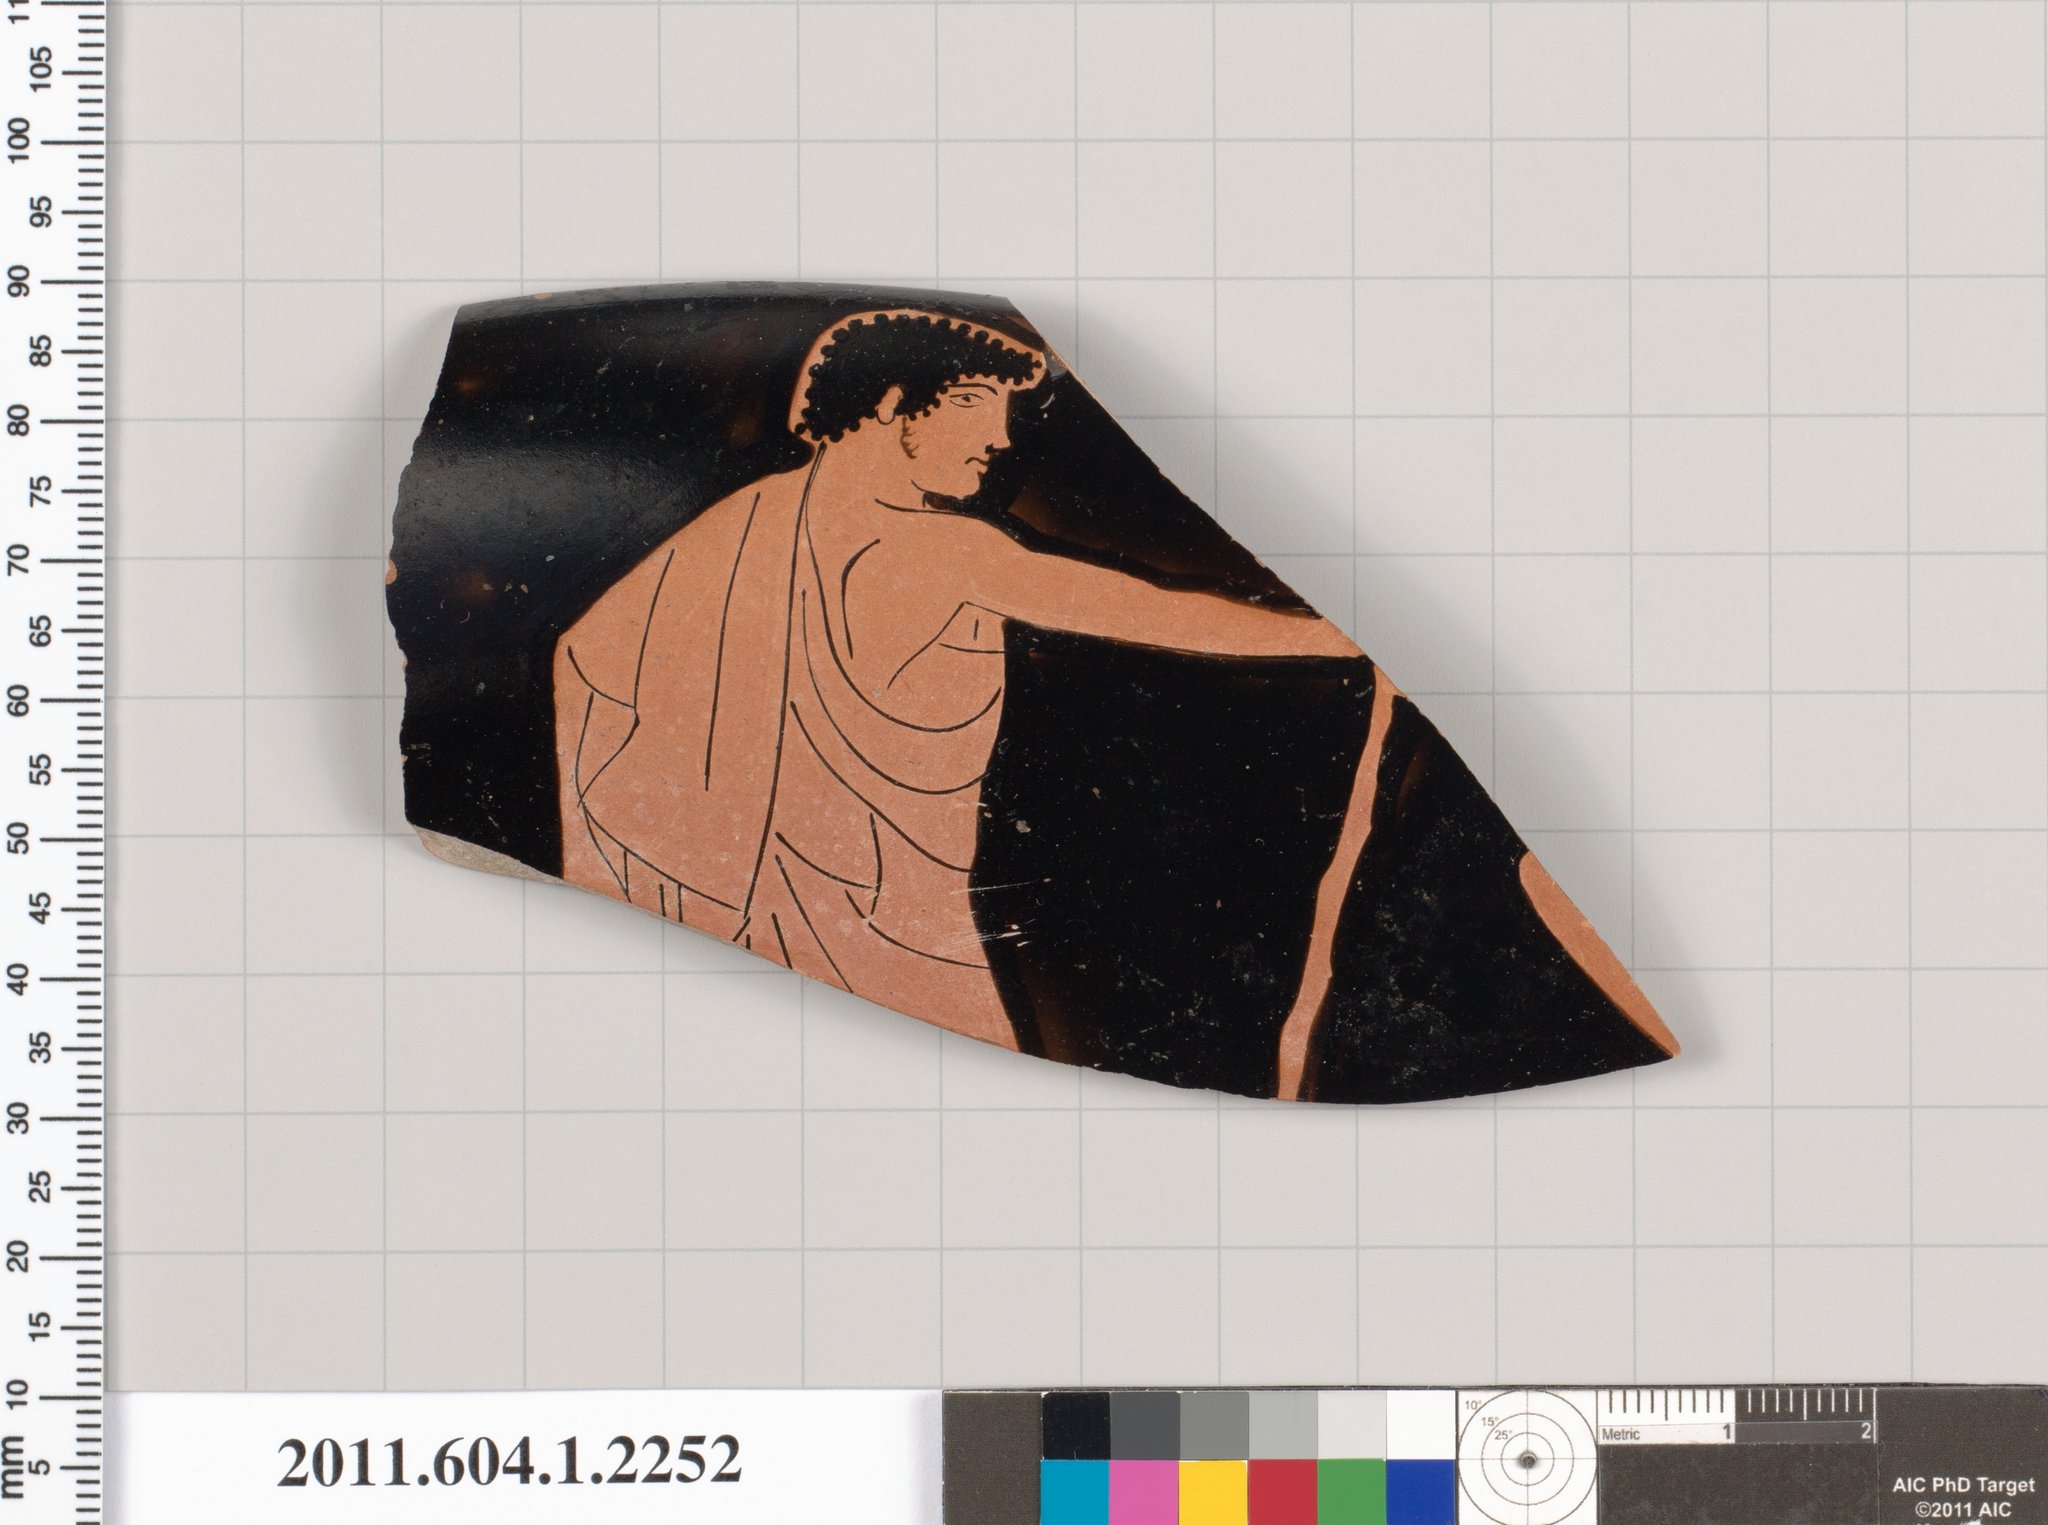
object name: kylix fragment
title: Terracotta rim fragment of a kylix (drinking cup)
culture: greek, attic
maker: ancona painter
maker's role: artist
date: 460-450 BCE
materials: terracotta